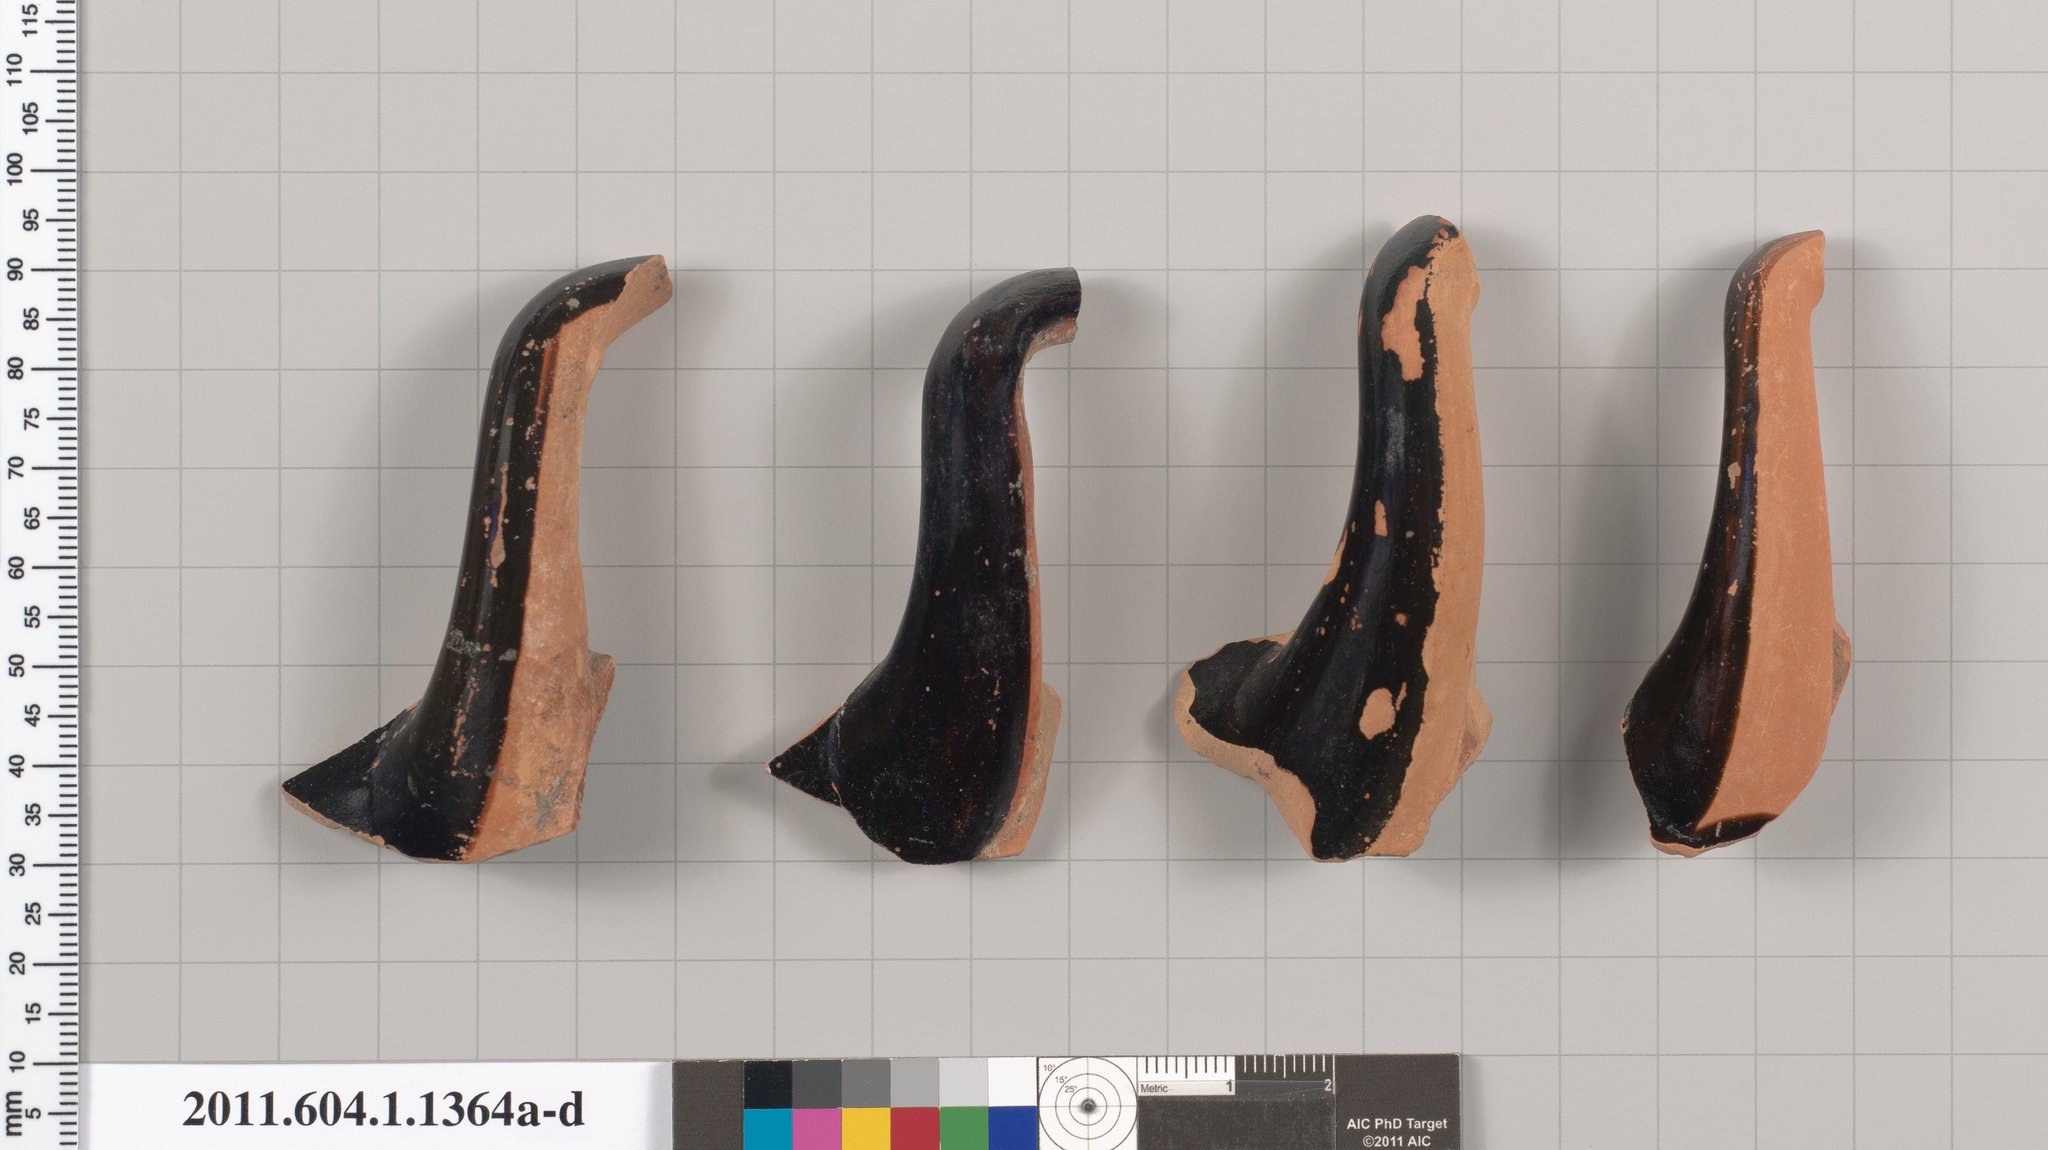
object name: kylix fragment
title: Terracotta fragments of kylikes (drinking cups)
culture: greek, attic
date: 500-401 BCE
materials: terracotta